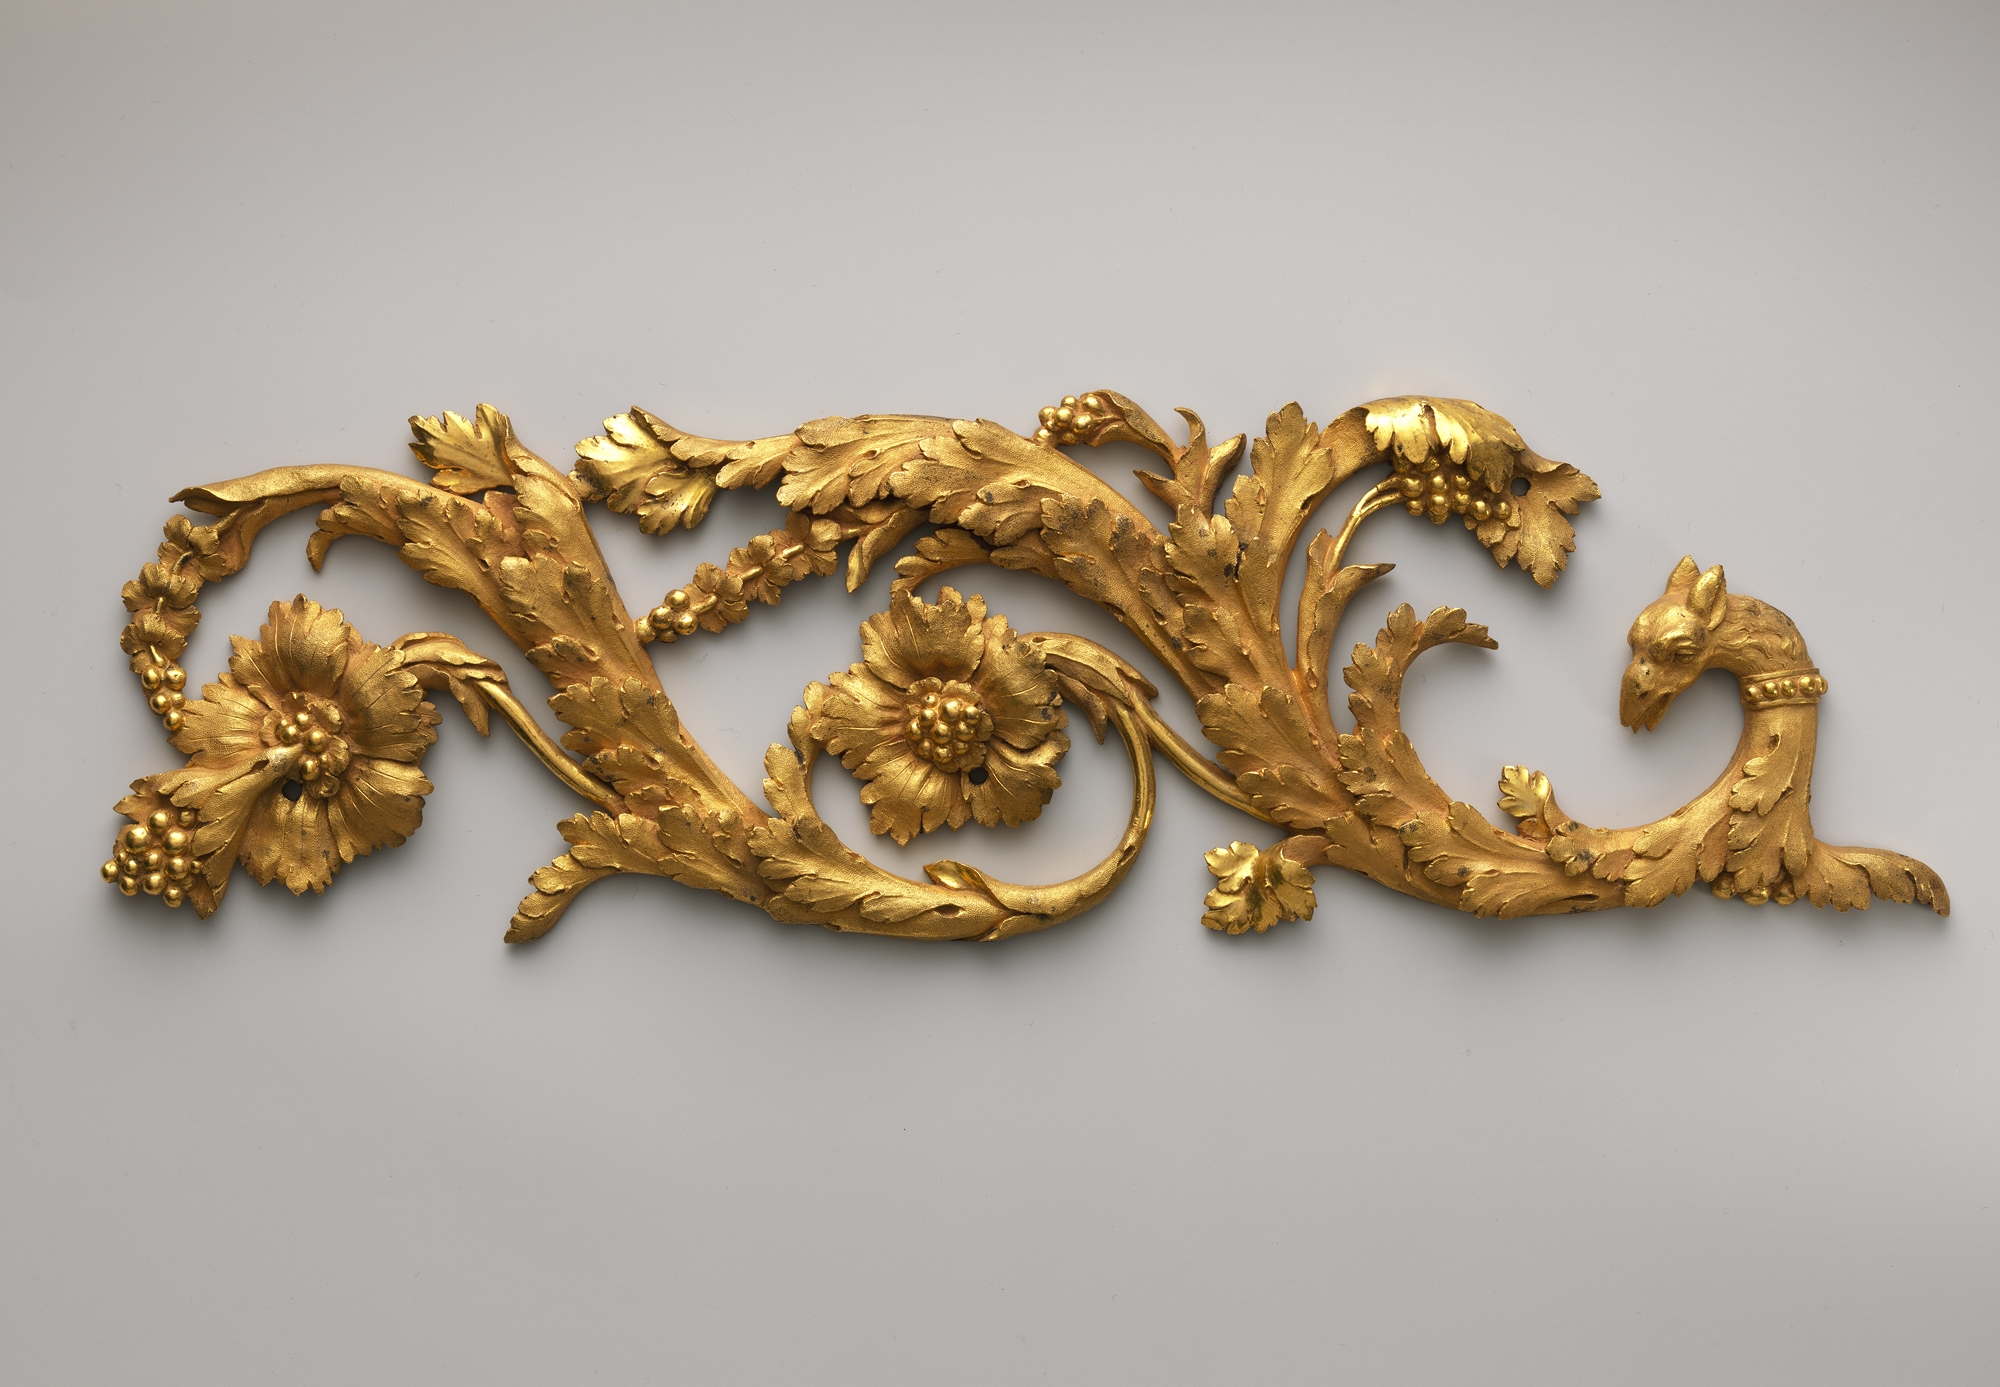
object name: frieze ornament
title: Pair of frieze ornaments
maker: etienne martincourt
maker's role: maker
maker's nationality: french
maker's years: 1762-1800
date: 1770-1785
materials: gilt bronze